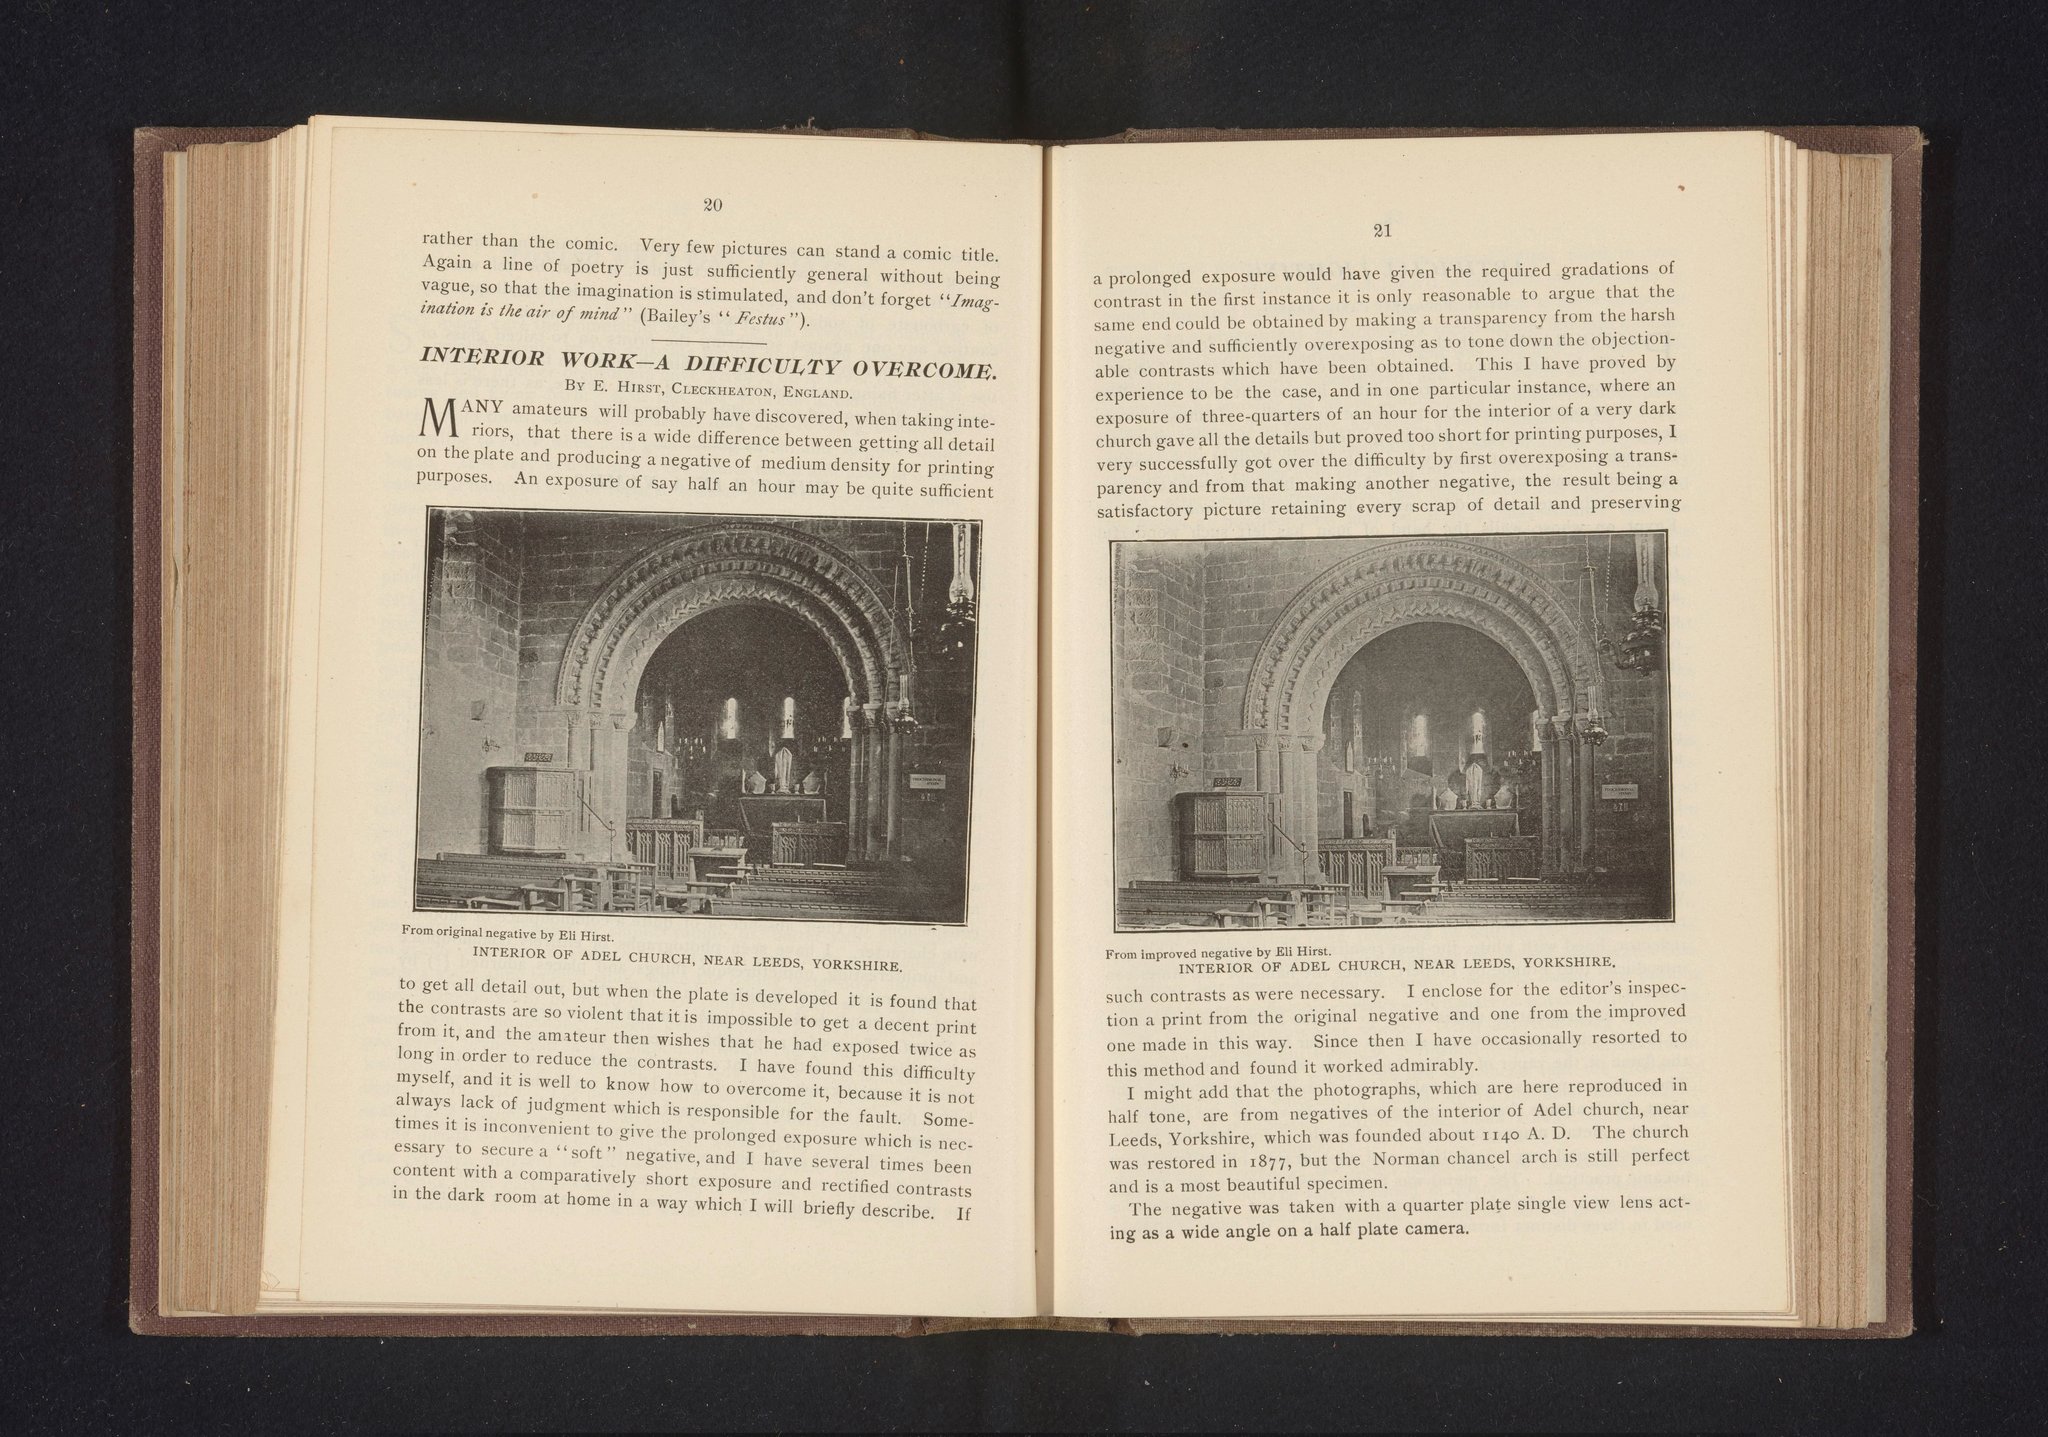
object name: photomechanical print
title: Interior of Adel Church, near Leeds, Yorkshire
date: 1890-1895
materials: paper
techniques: autotype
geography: saint john the baptist church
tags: adult woman